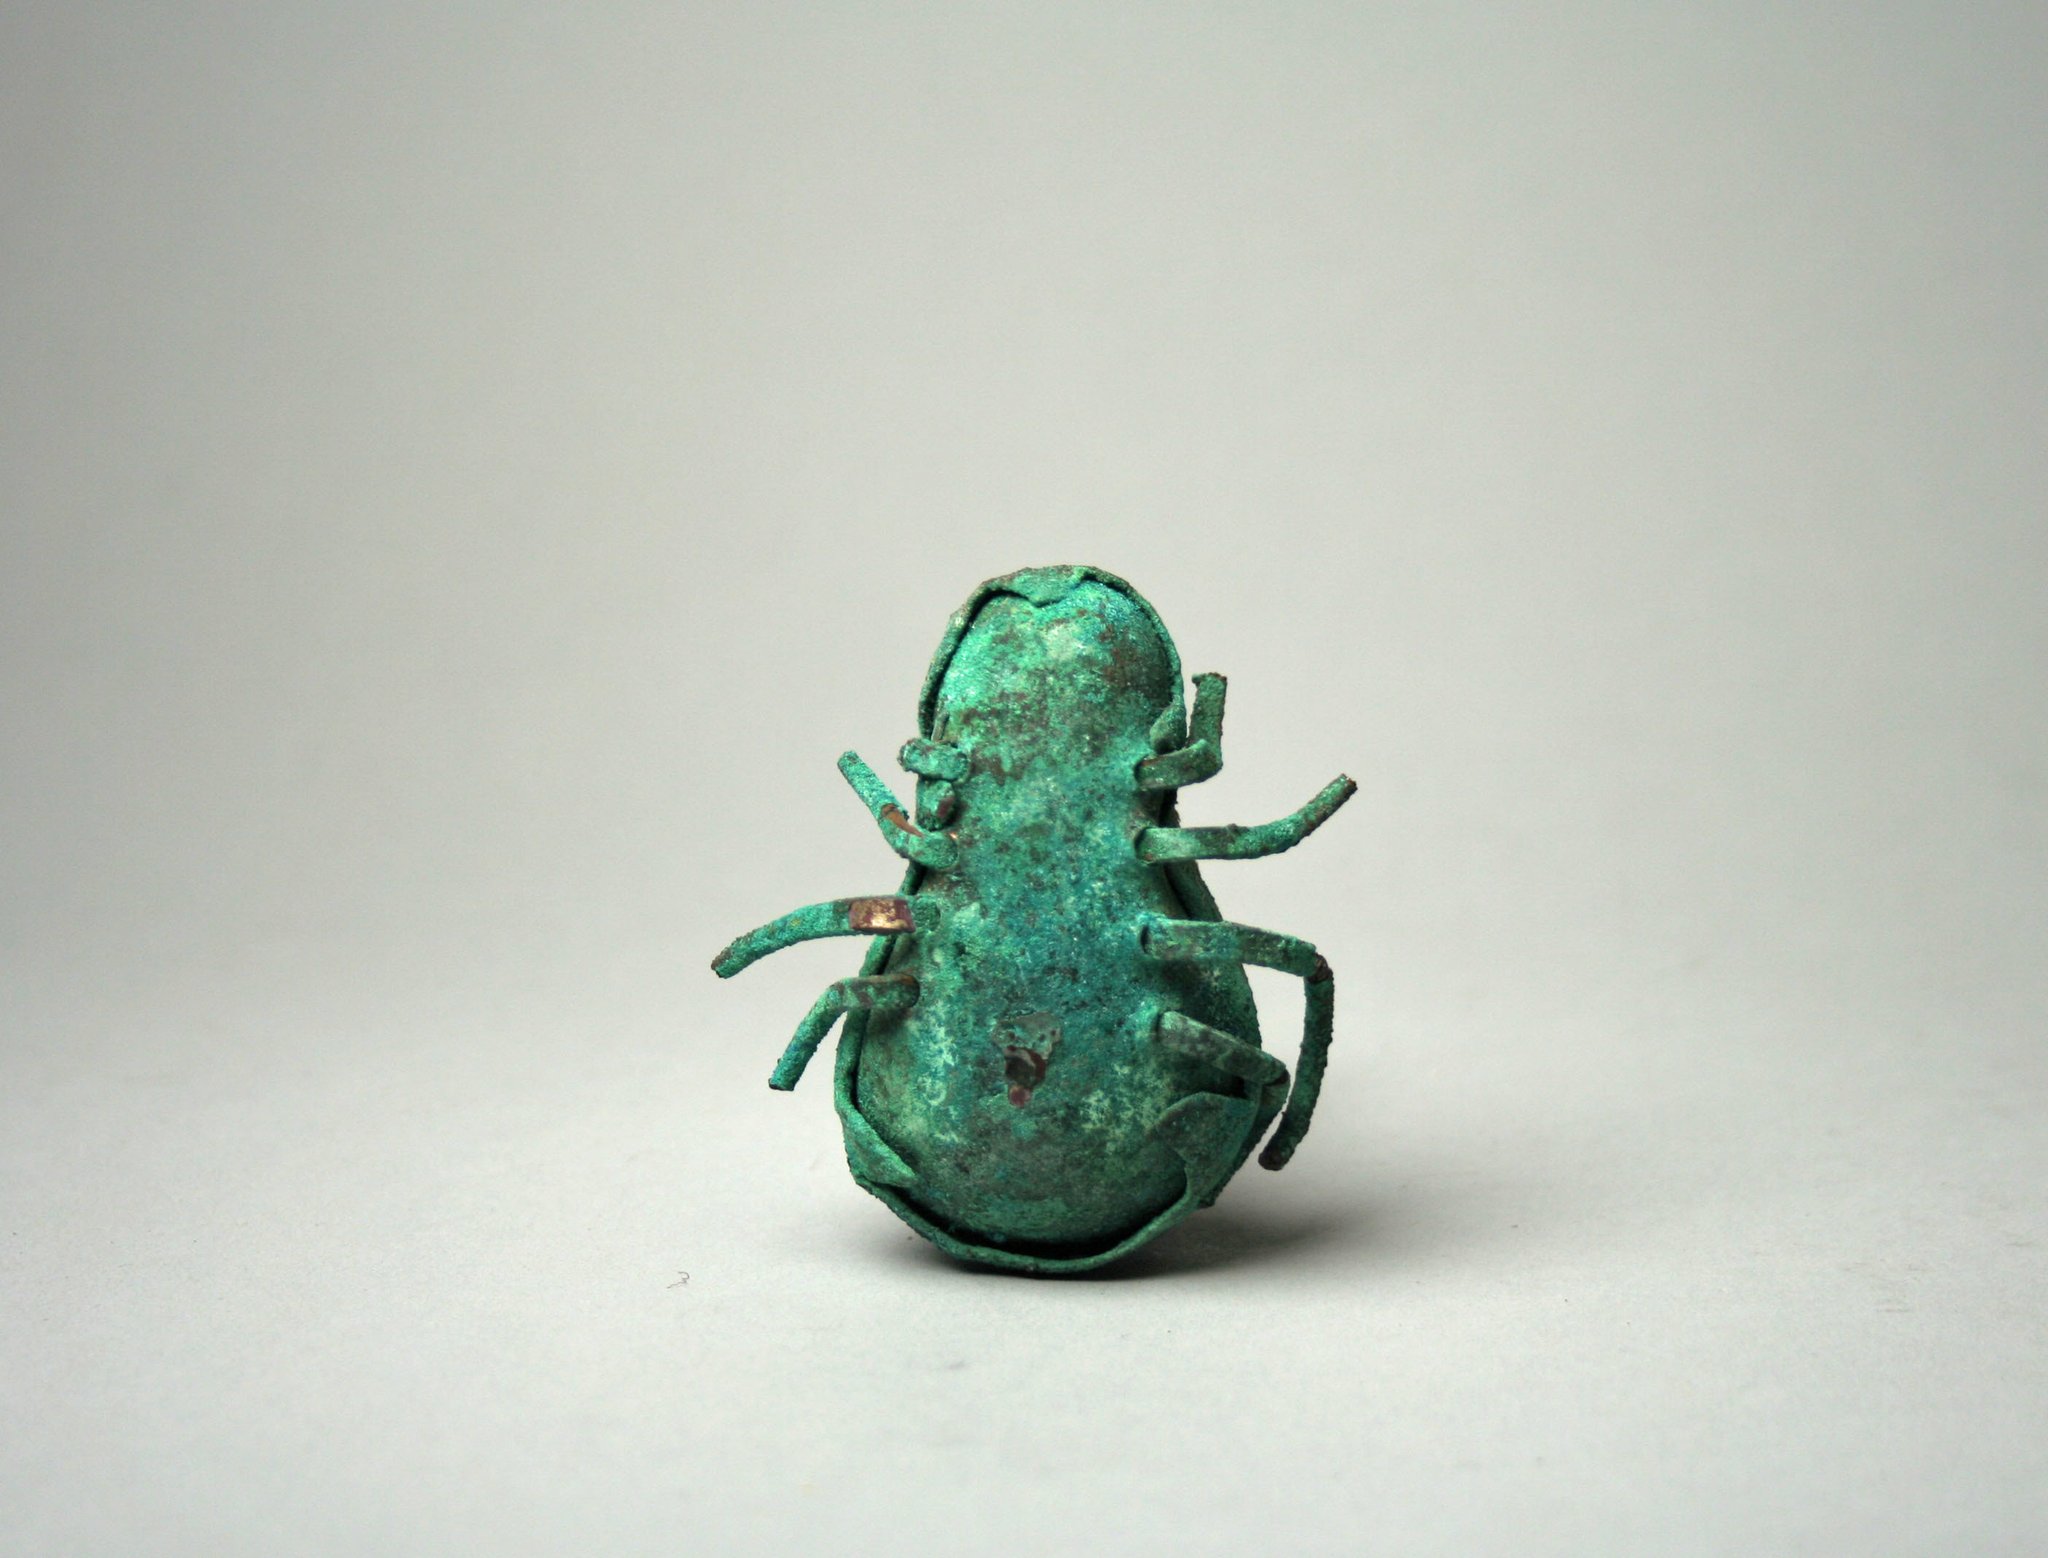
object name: ornament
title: Spider Ornament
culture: moche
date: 501-700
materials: copper, gilt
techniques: hammering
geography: peru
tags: insects